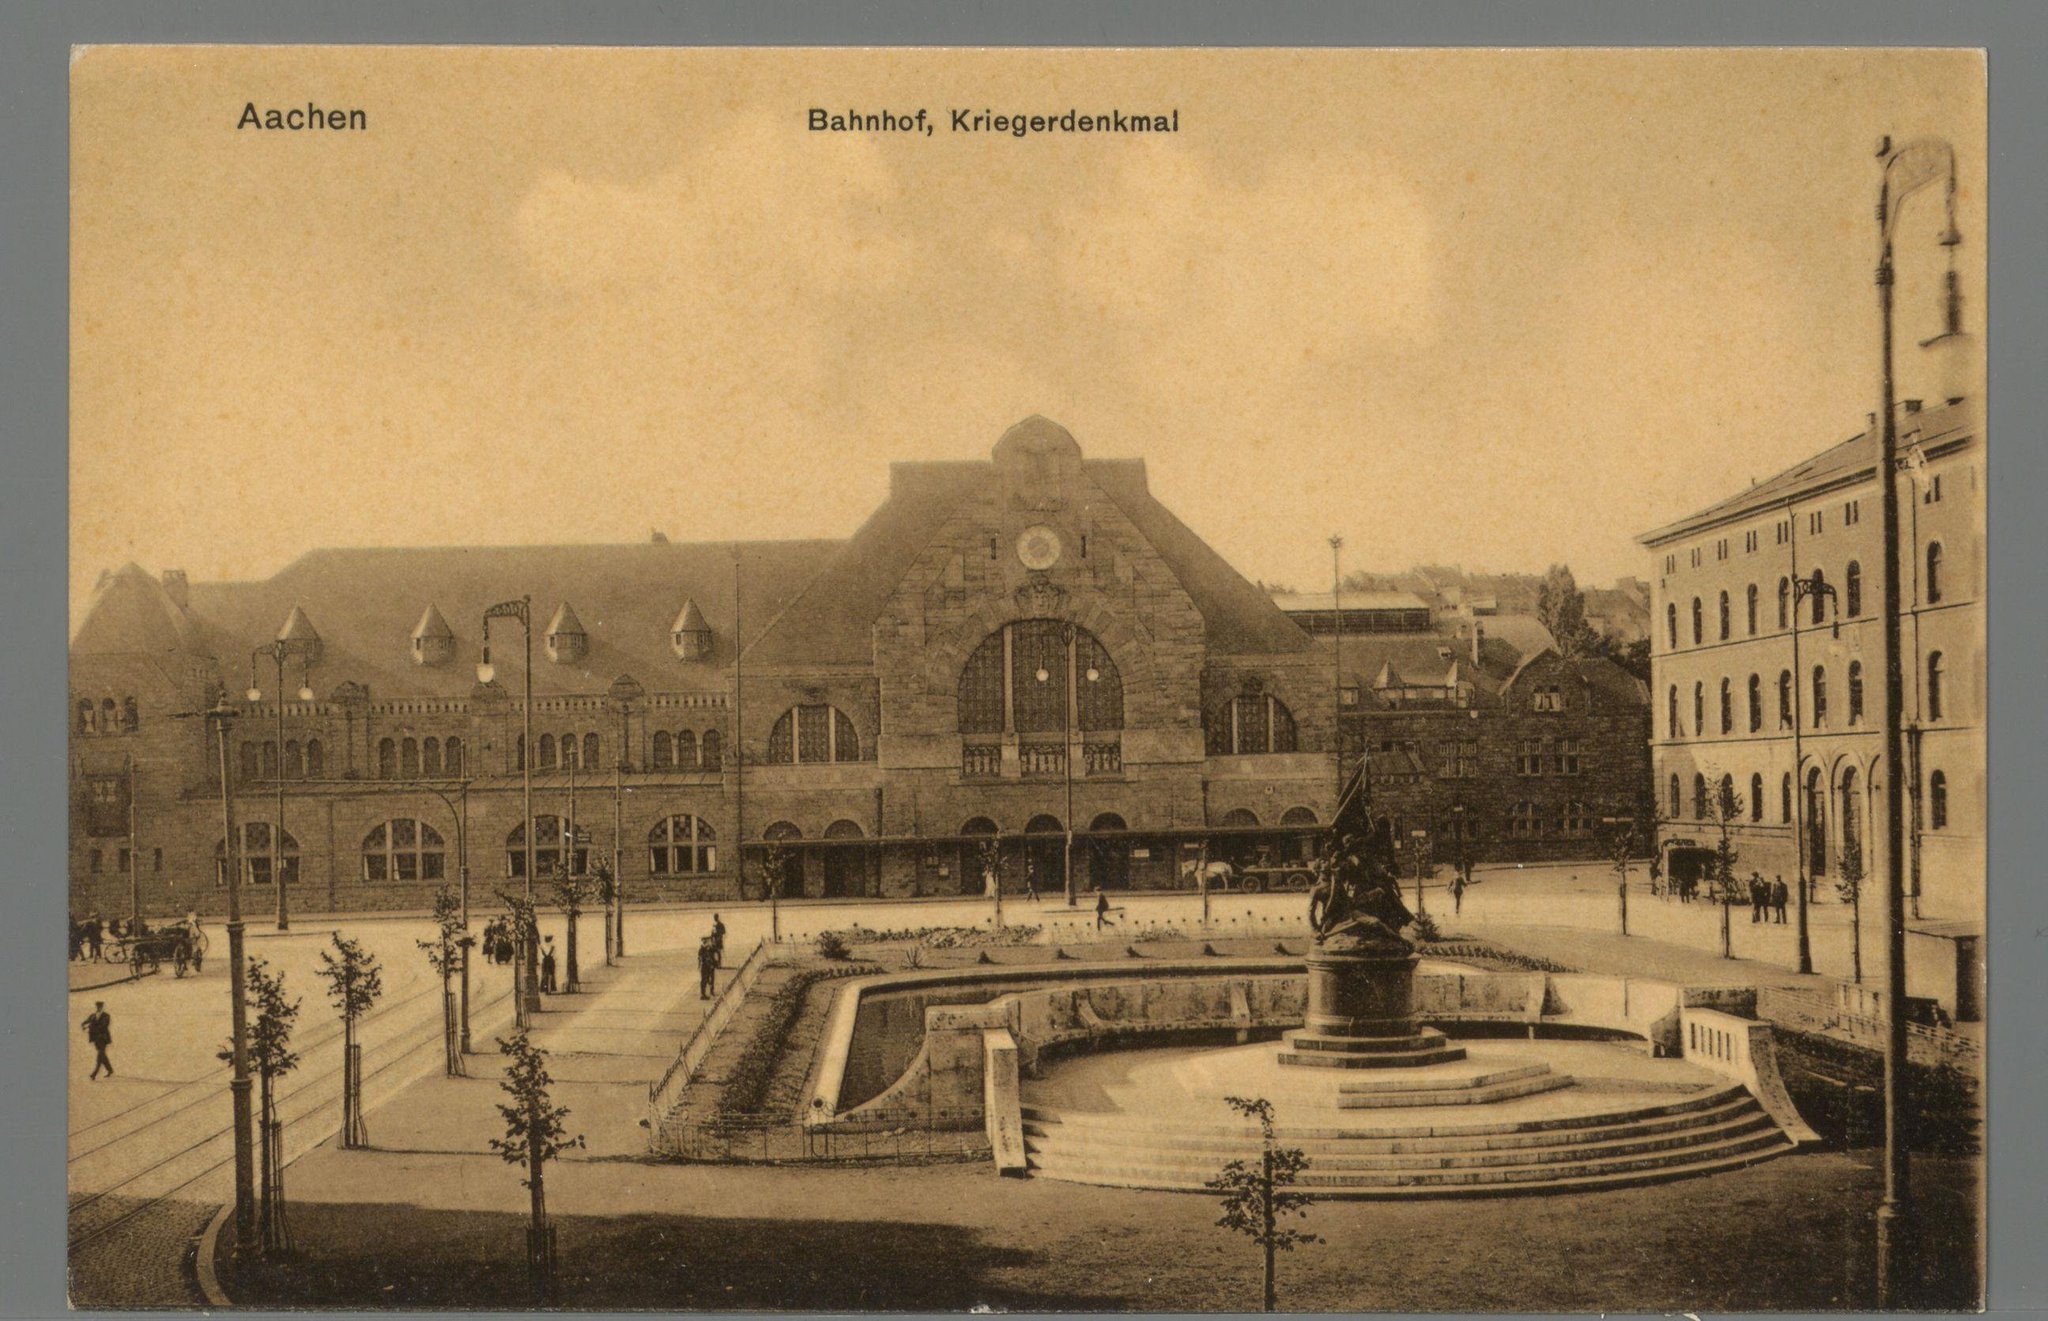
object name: photomechanical print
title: Aachen. Bahnhof, Kriegerdenkmal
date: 1905-1906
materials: cardboard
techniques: photograph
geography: aachen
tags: monument, statue, station; shelter (railway, tramway)